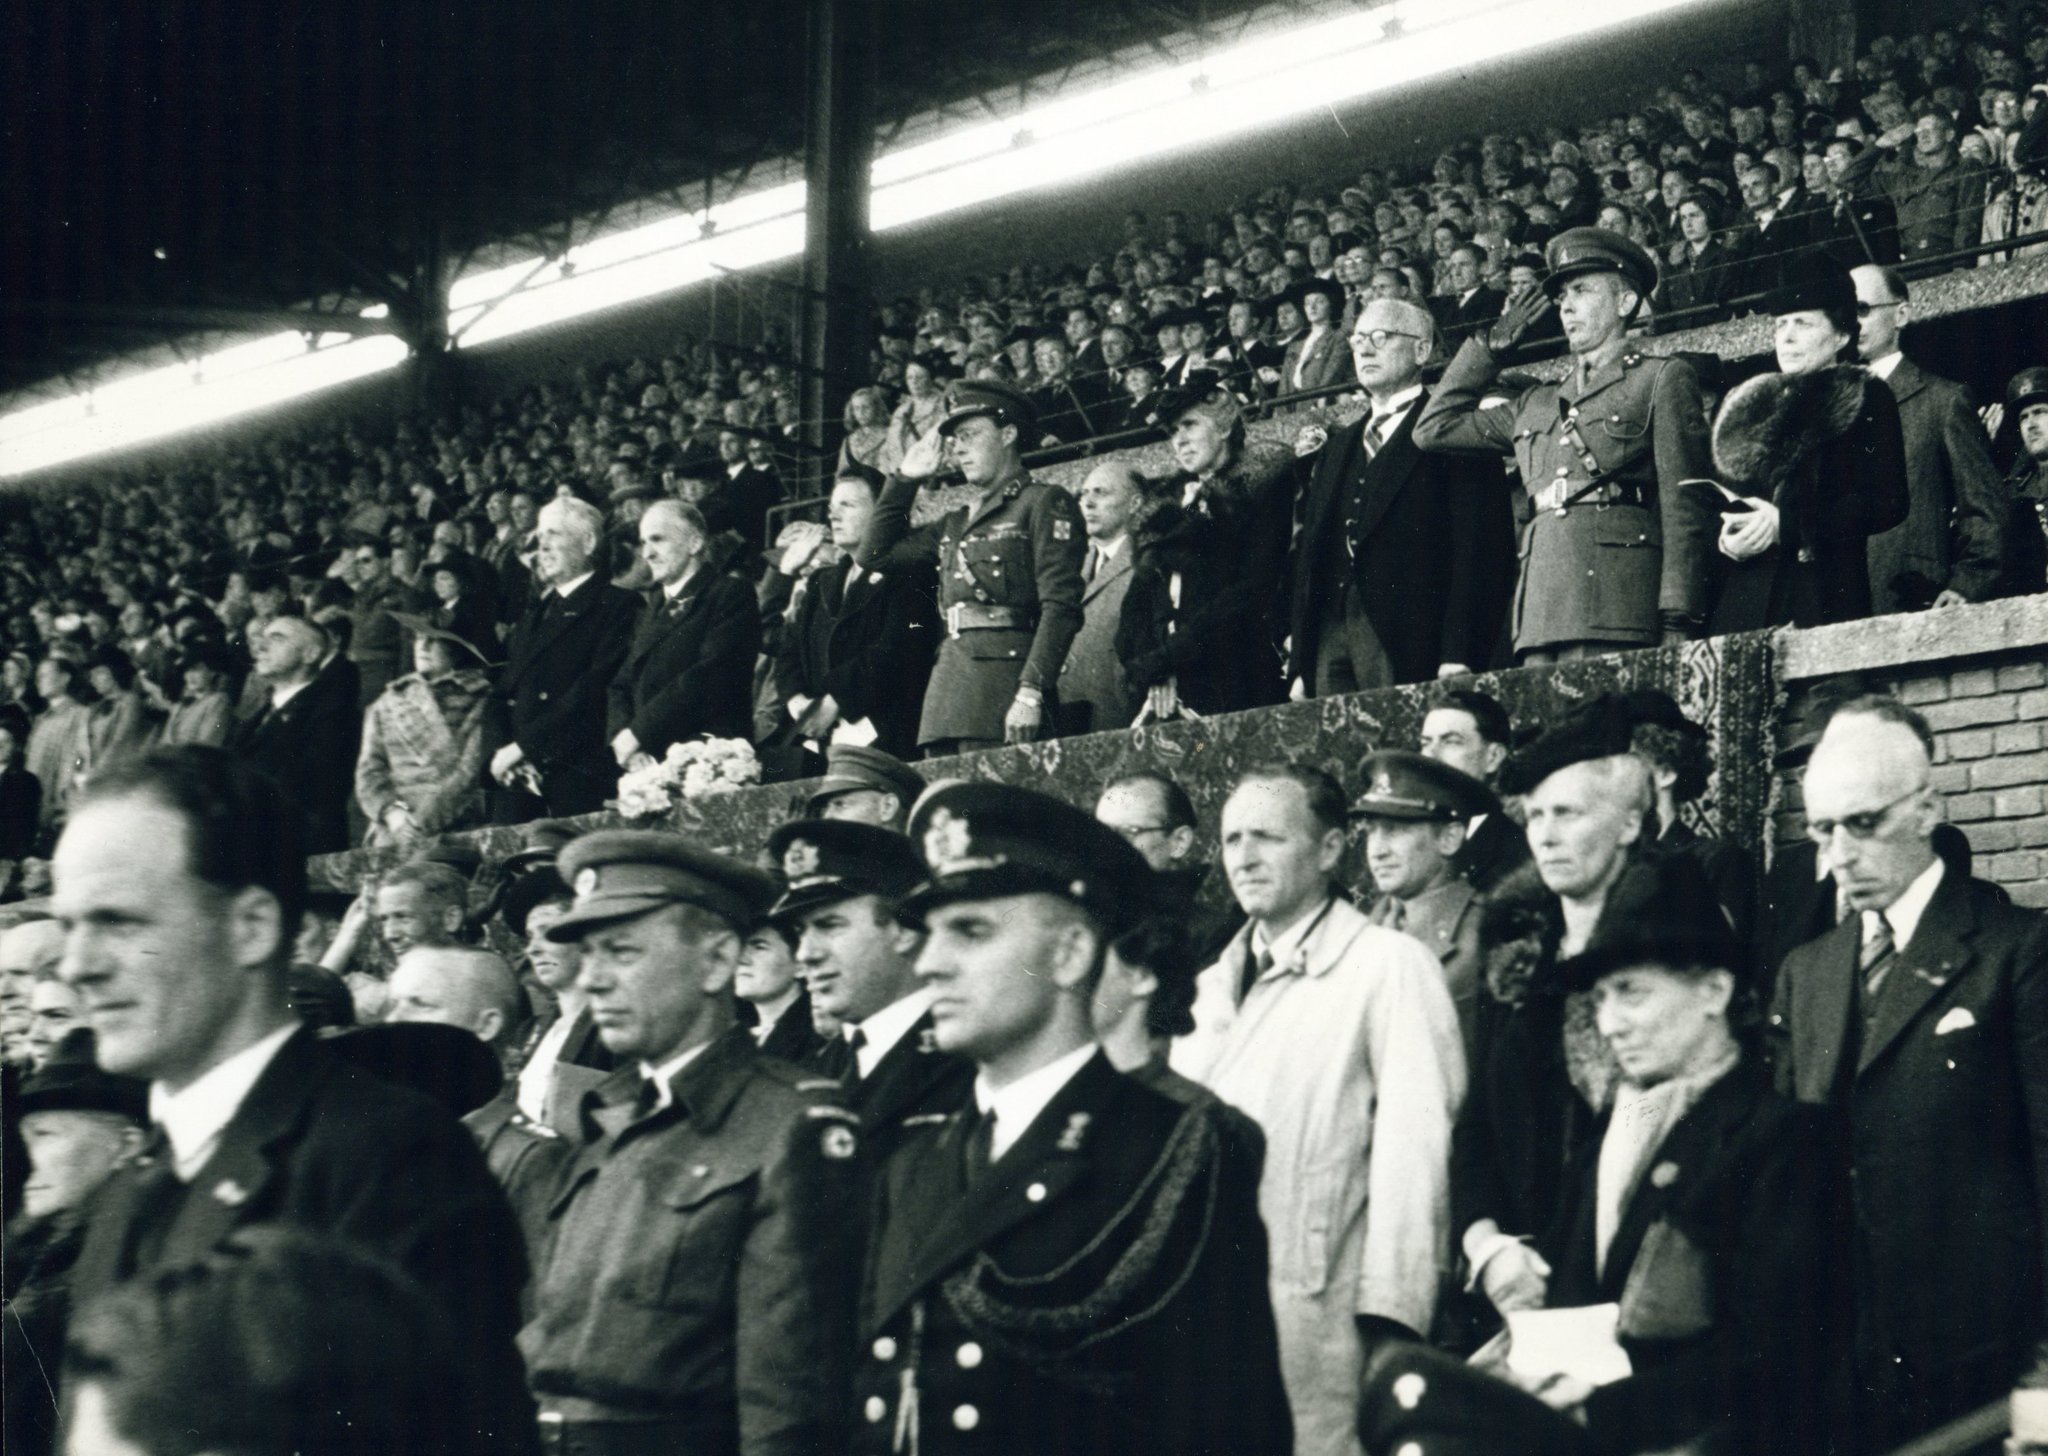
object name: documentary photograph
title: Eerste nationale bevrijdingsfeest in het Olympisch Stadion: de tribune met prominenten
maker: casparus bernardus oorthuijs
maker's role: fotograaf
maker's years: 1908-1975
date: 1945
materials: photographic support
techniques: photography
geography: amsterdam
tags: utrecht, bernhard (prins der nederlanden), the hague, pieter sjoerds gerbrandy, mayor, juliana of the netherlands, amsterdam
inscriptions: number: ‘6838’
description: De regering Gerbrandy besloot dat het eerste nationale bevrijdingsfeest zou worden gehouden op de verjaardag van koningin Wilhelmina. Op 31 augustus 1945 werd er dan ook een grote theatrale manifestatie georganiseerd in het Olympisch Stadion te Amsterdam. De eretribune van het Olympische Stadion. Met van links naar rechts jonkheer de Vos van Steenwijk, prinses Juliana, prins Bernhard, mevrouw de Vos van Steenwijk en burgemeester De Boer van Amsterdam.